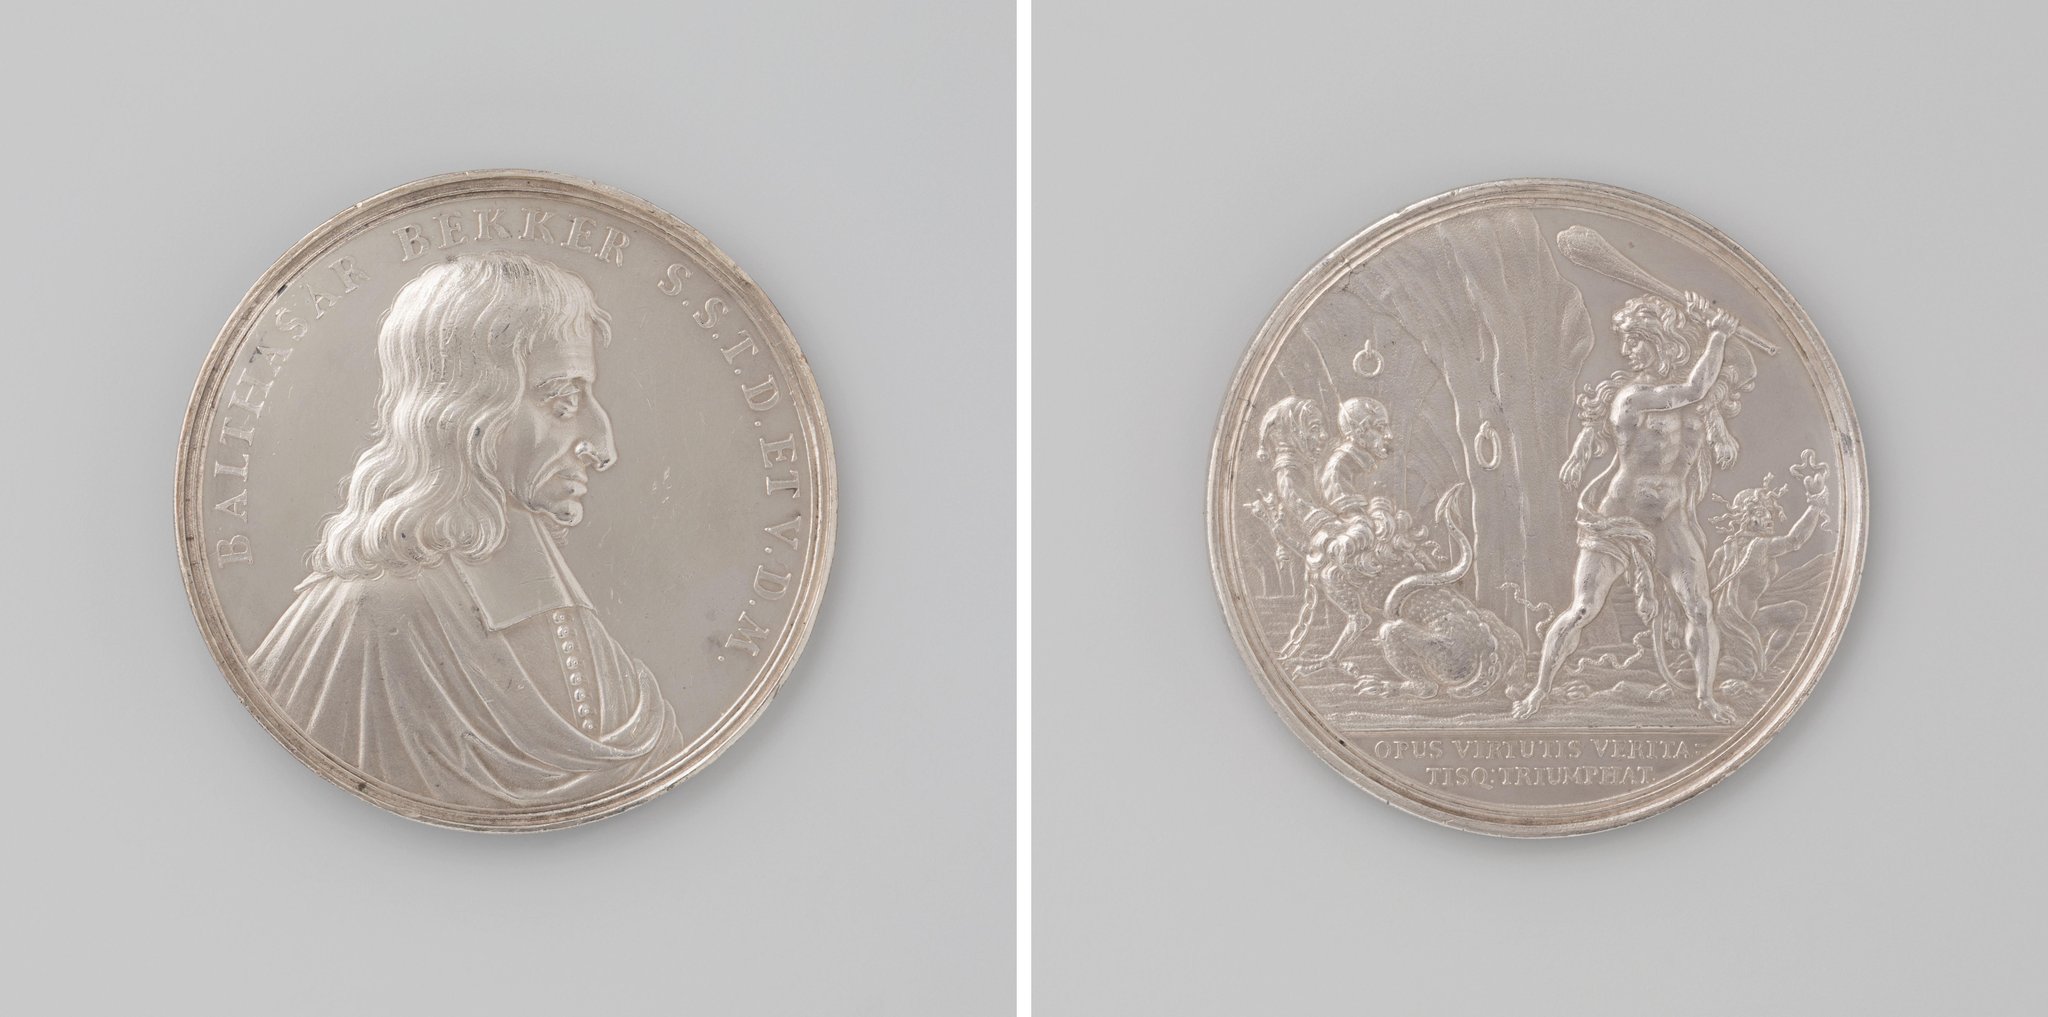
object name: history medal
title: Balthasar Bekker, predikant te Amsterdam, door de synode te Alkmaar afgezet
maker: Anonymous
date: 1698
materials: silver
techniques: striking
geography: netherlands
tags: balthasar bekker, amsterdam